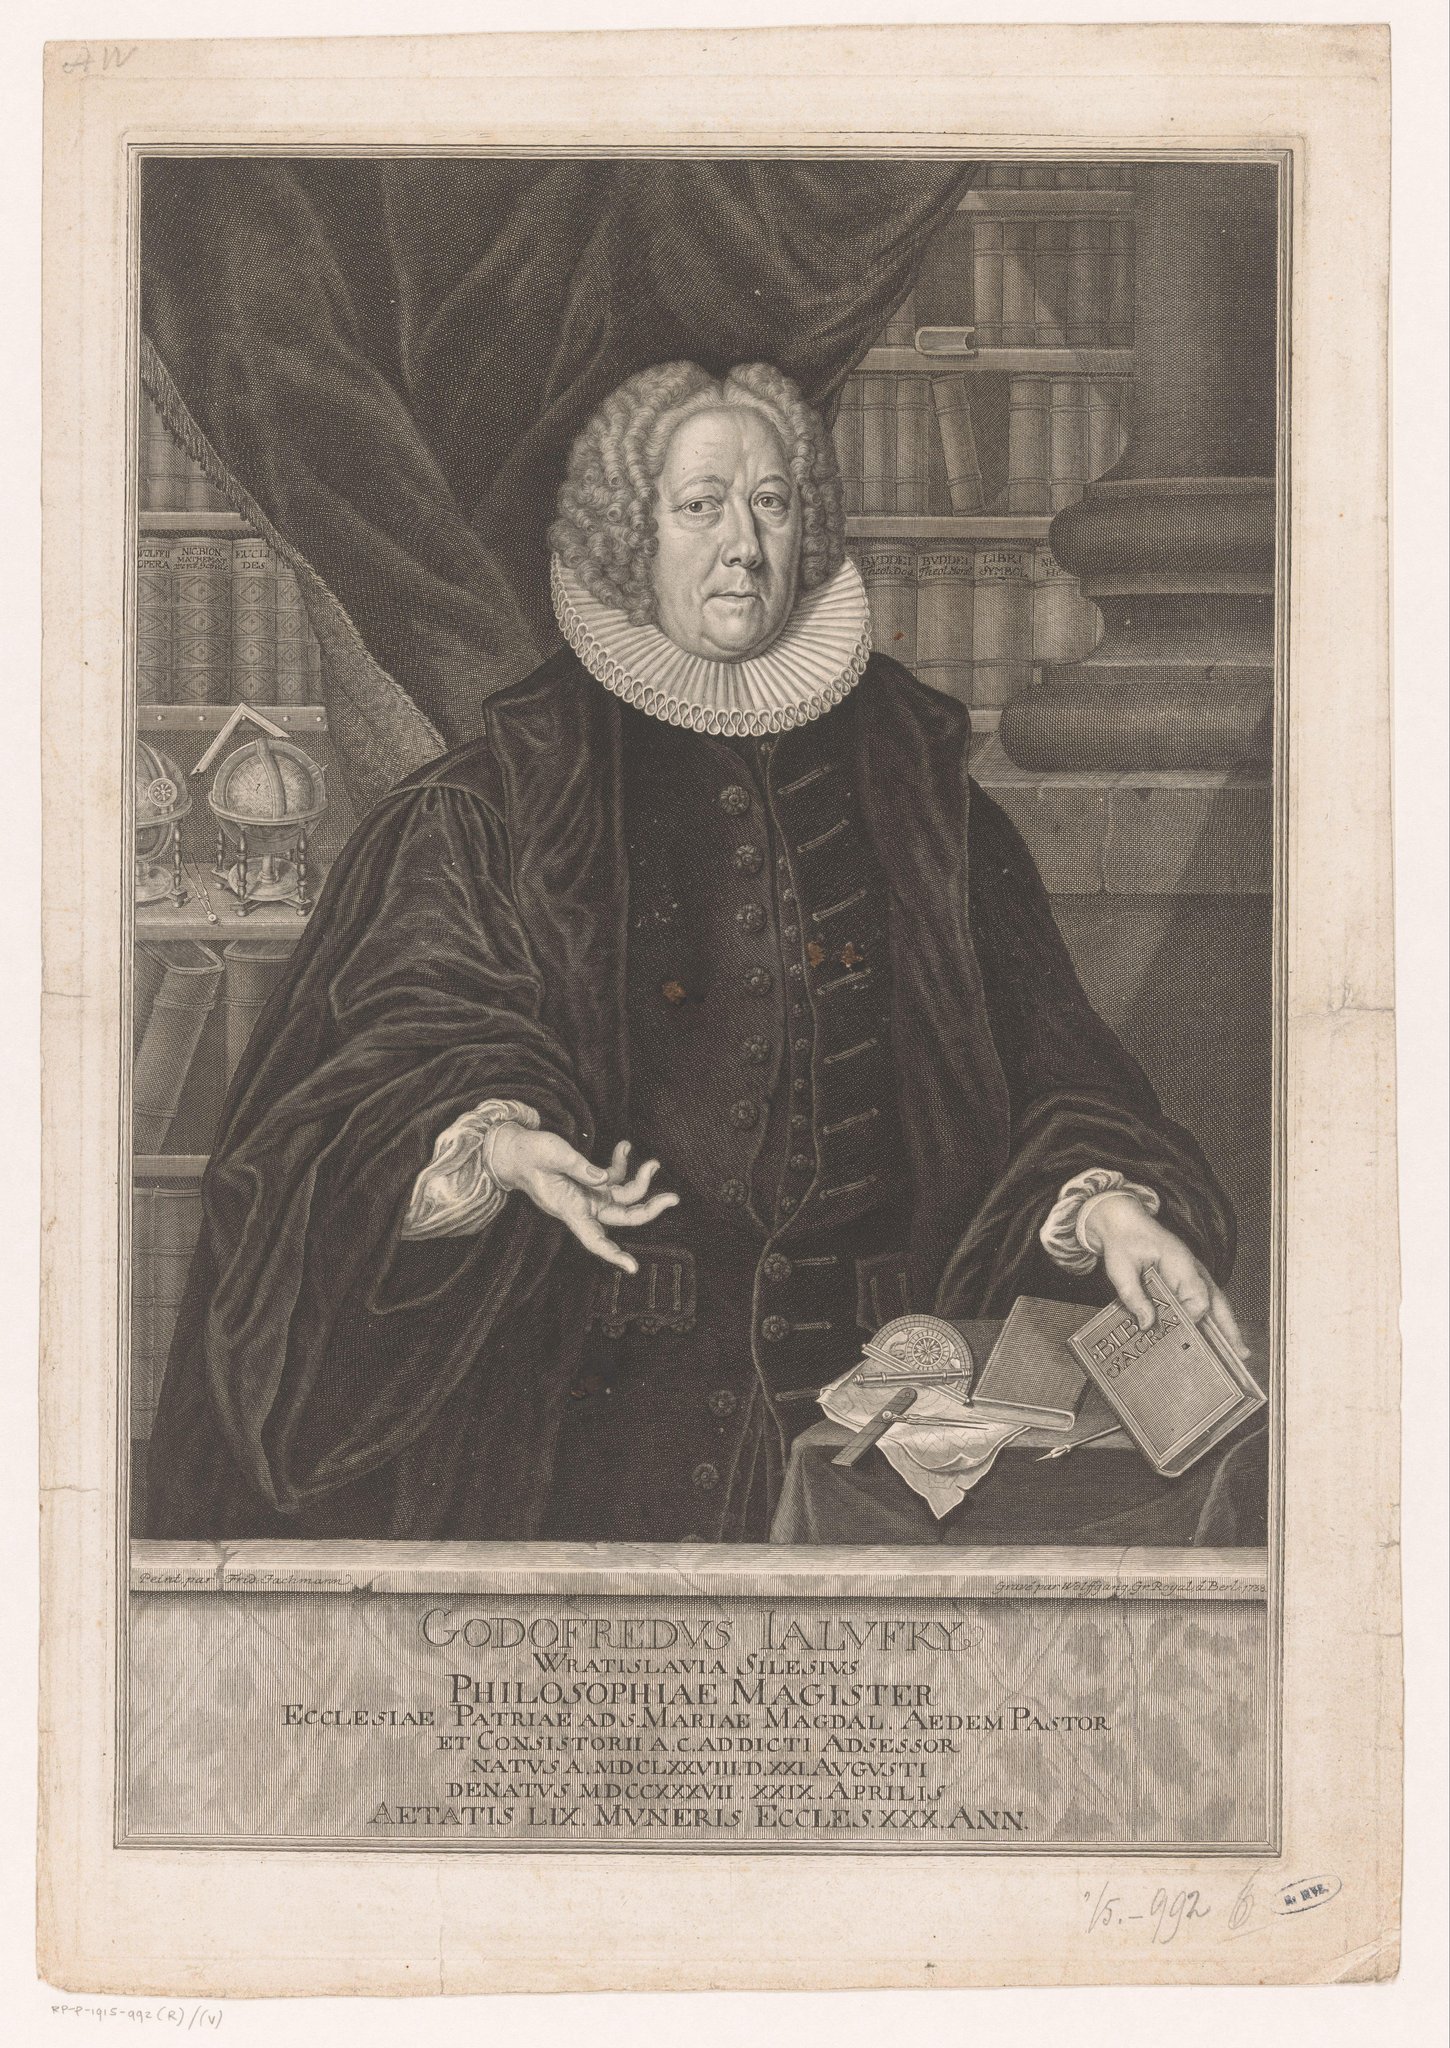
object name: print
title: Portret van Gottfried Jalufky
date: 1738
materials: paper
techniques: engraving, etching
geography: berlin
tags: historical persons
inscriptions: collector's mark: Lugt 2228